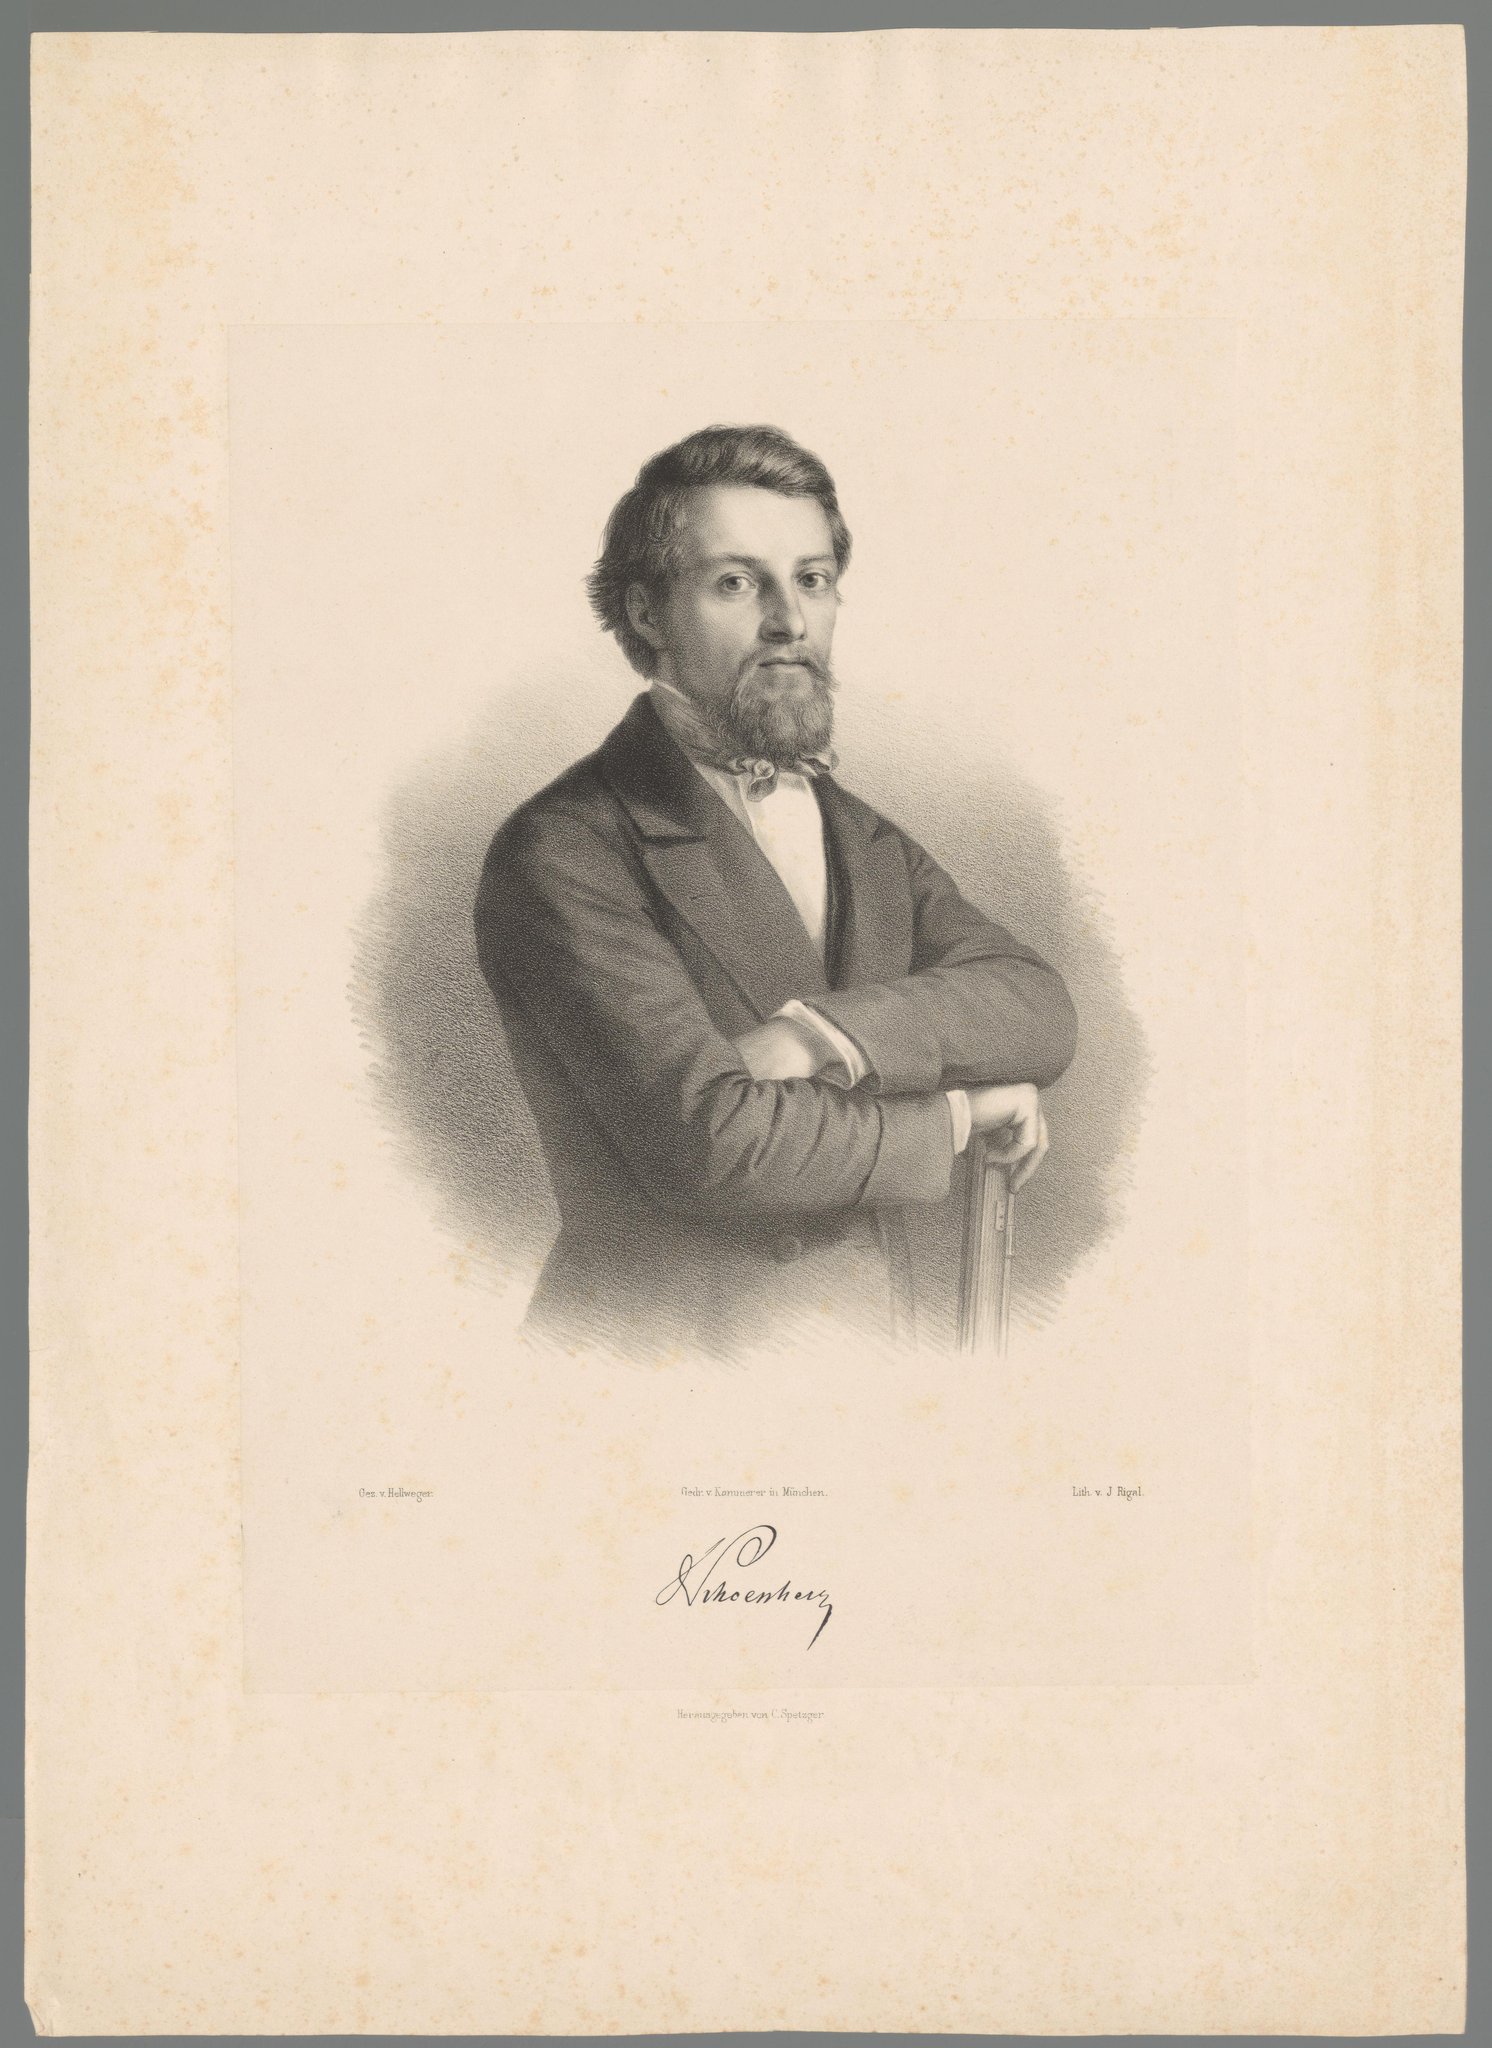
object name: print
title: Portret van Karl Schönherr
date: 1822-1880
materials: paper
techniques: lithograph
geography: munich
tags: vienna, historical persons, portrait of a writer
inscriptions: collector's mark: Lugt 2228